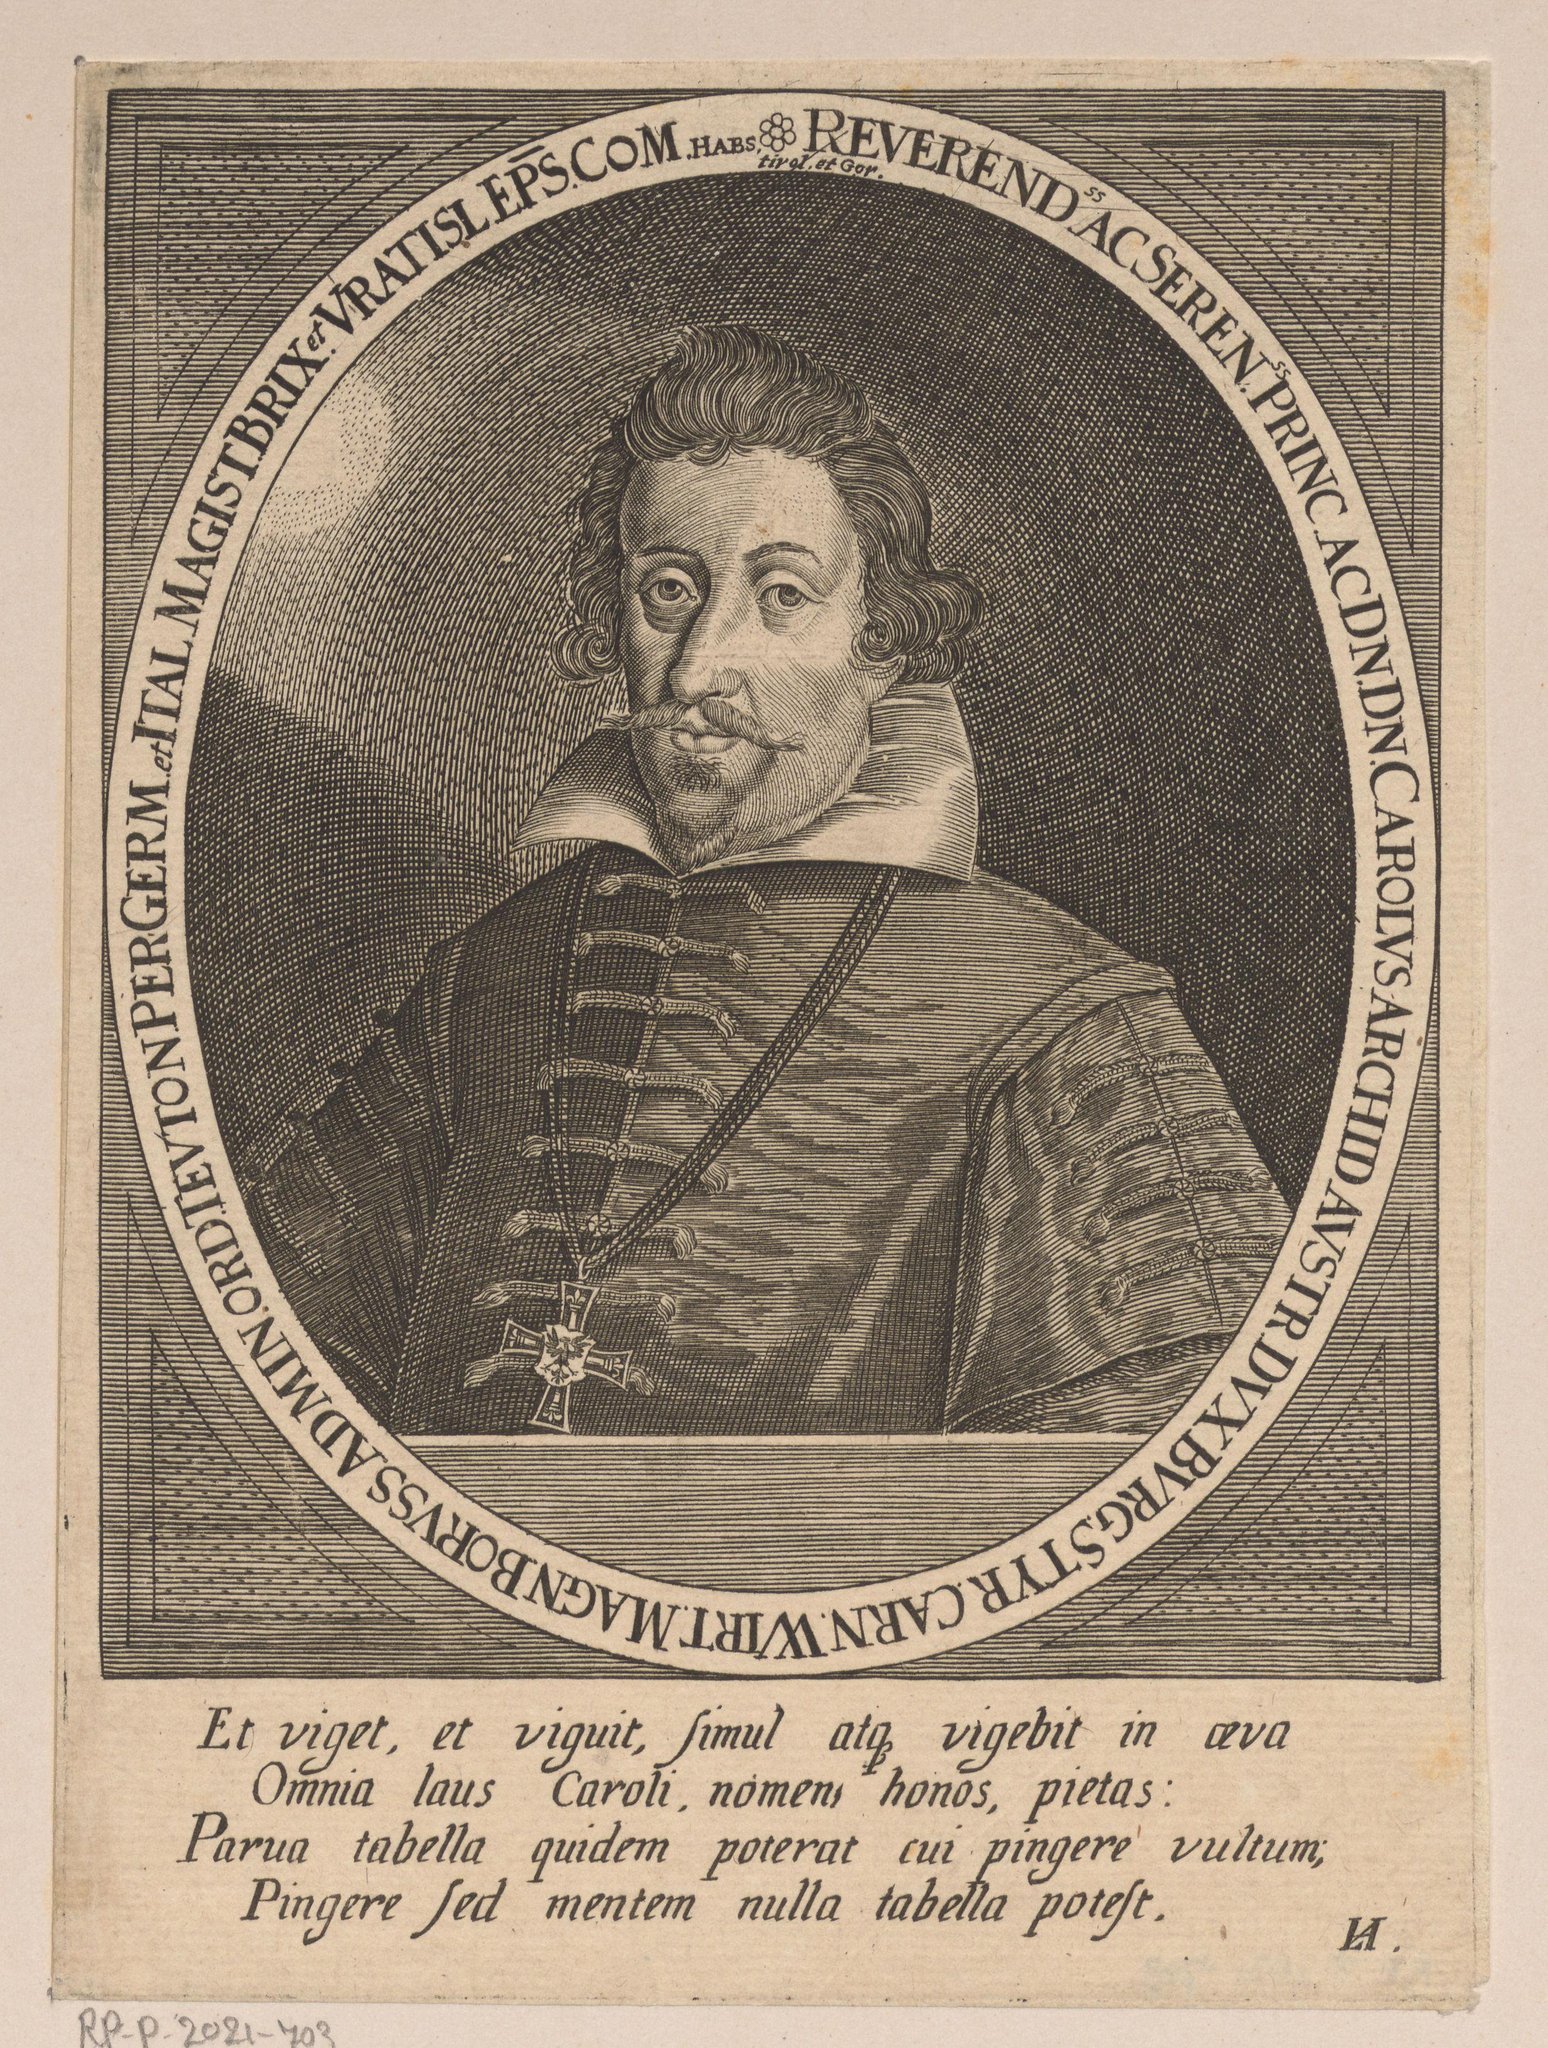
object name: print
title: Portret van Karel van Oostenrijk, vorstbisschop van Breslau en bisschop van Brixen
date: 1629-1641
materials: paper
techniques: engraving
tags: other sovereign, historical persons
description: Prent mogelijk uit: Bellus, Nicolaus. Heldenbuch. Frankfurt am Main: Erasmus Kempffer, 1629. Prent ook gebruikt in latere publicaties (1632, 1641).